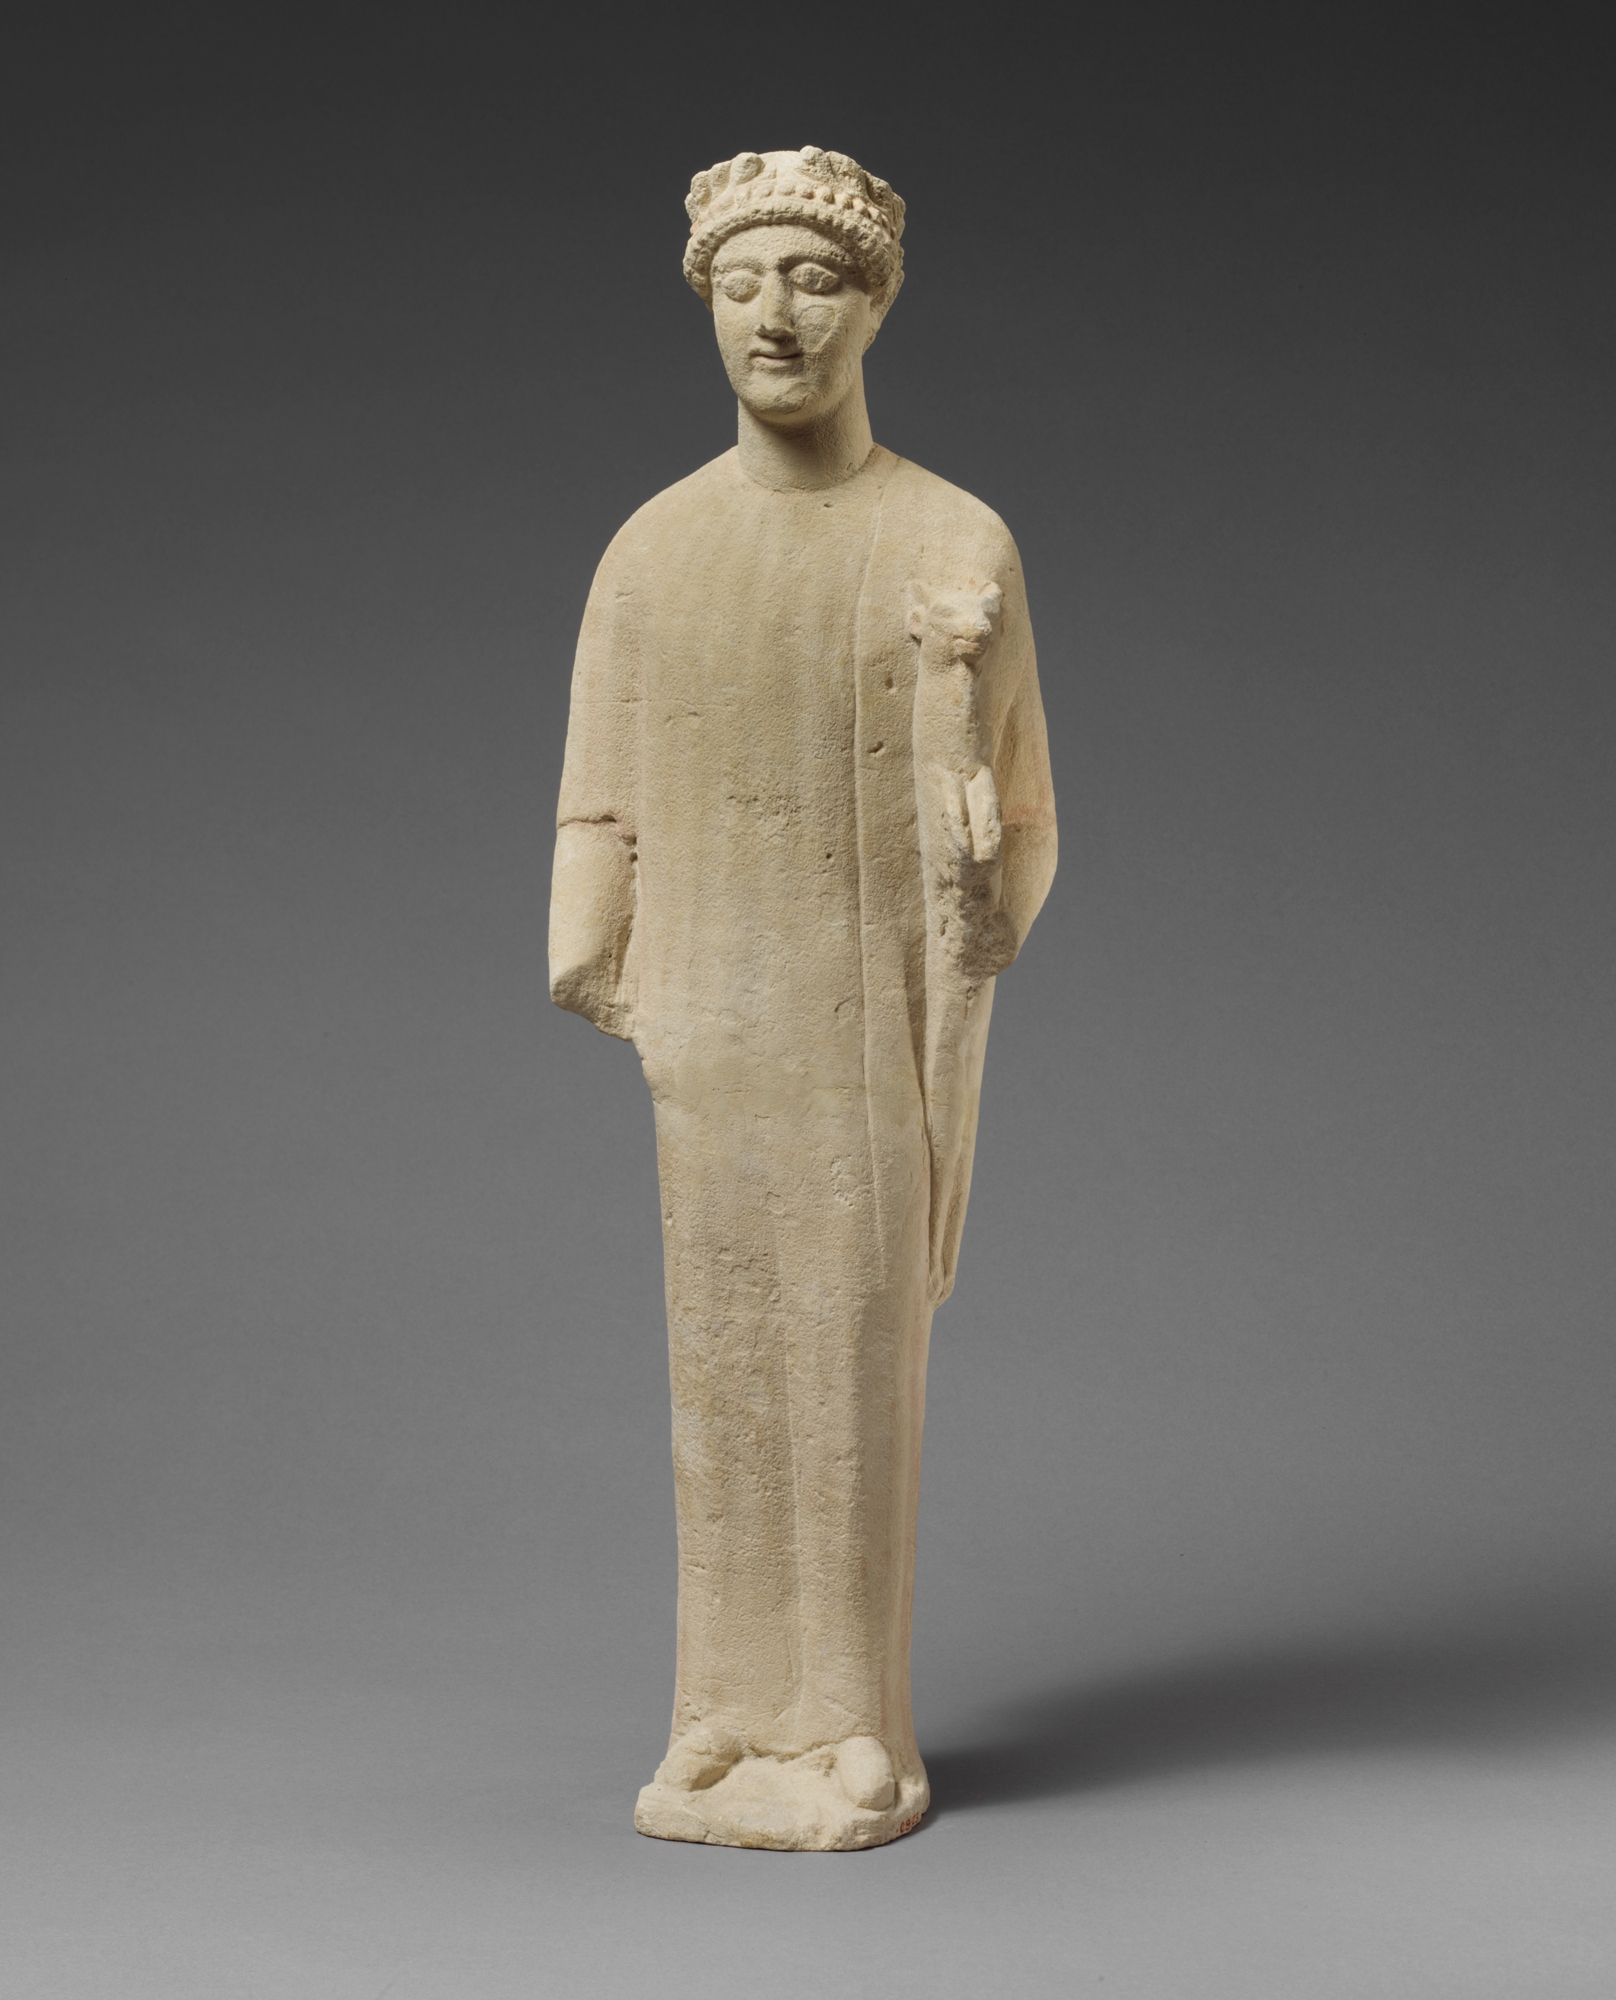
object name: statue of a votary, male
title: Limestone statuette of a beardless male votary with a wreath of leaves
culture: cypriot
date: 450-401 BCE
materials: limestone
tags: men,goats